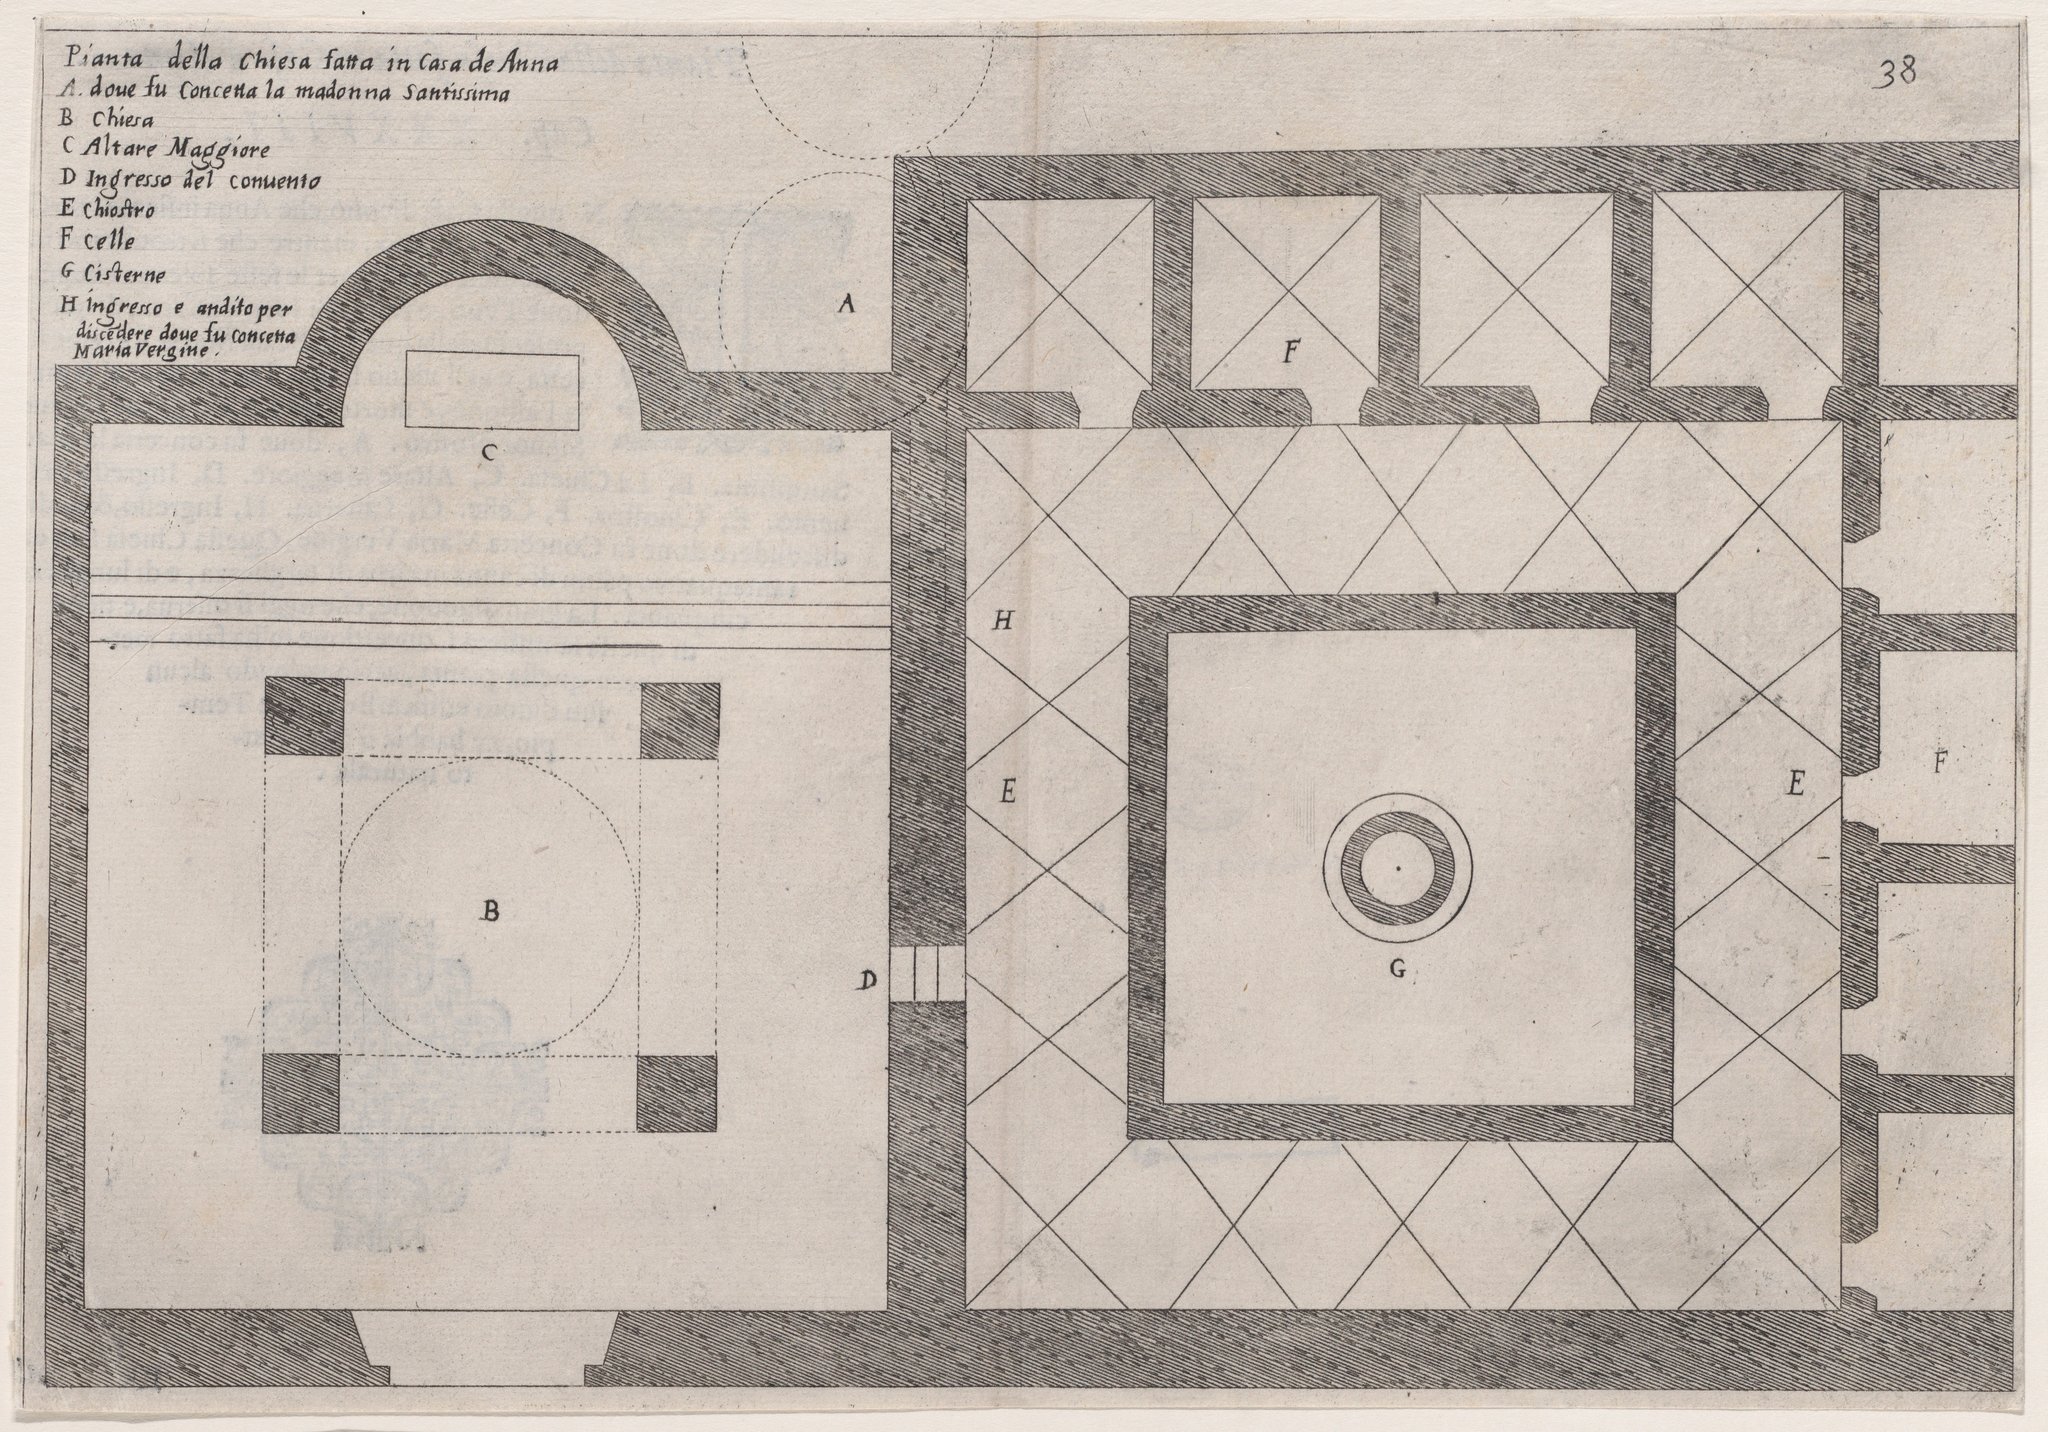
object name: print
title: Plate 31, from "Trattato delle Piante & Immagini de Sacri Edifizi di Terra Santa" (Treatise of the Plans & Images of the Sacred Buildings of the Holy Land)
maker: jacques callot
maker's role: artist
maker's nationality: french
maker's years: 1592-1635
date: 1620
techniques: engraving, etching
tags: architecture,buildings